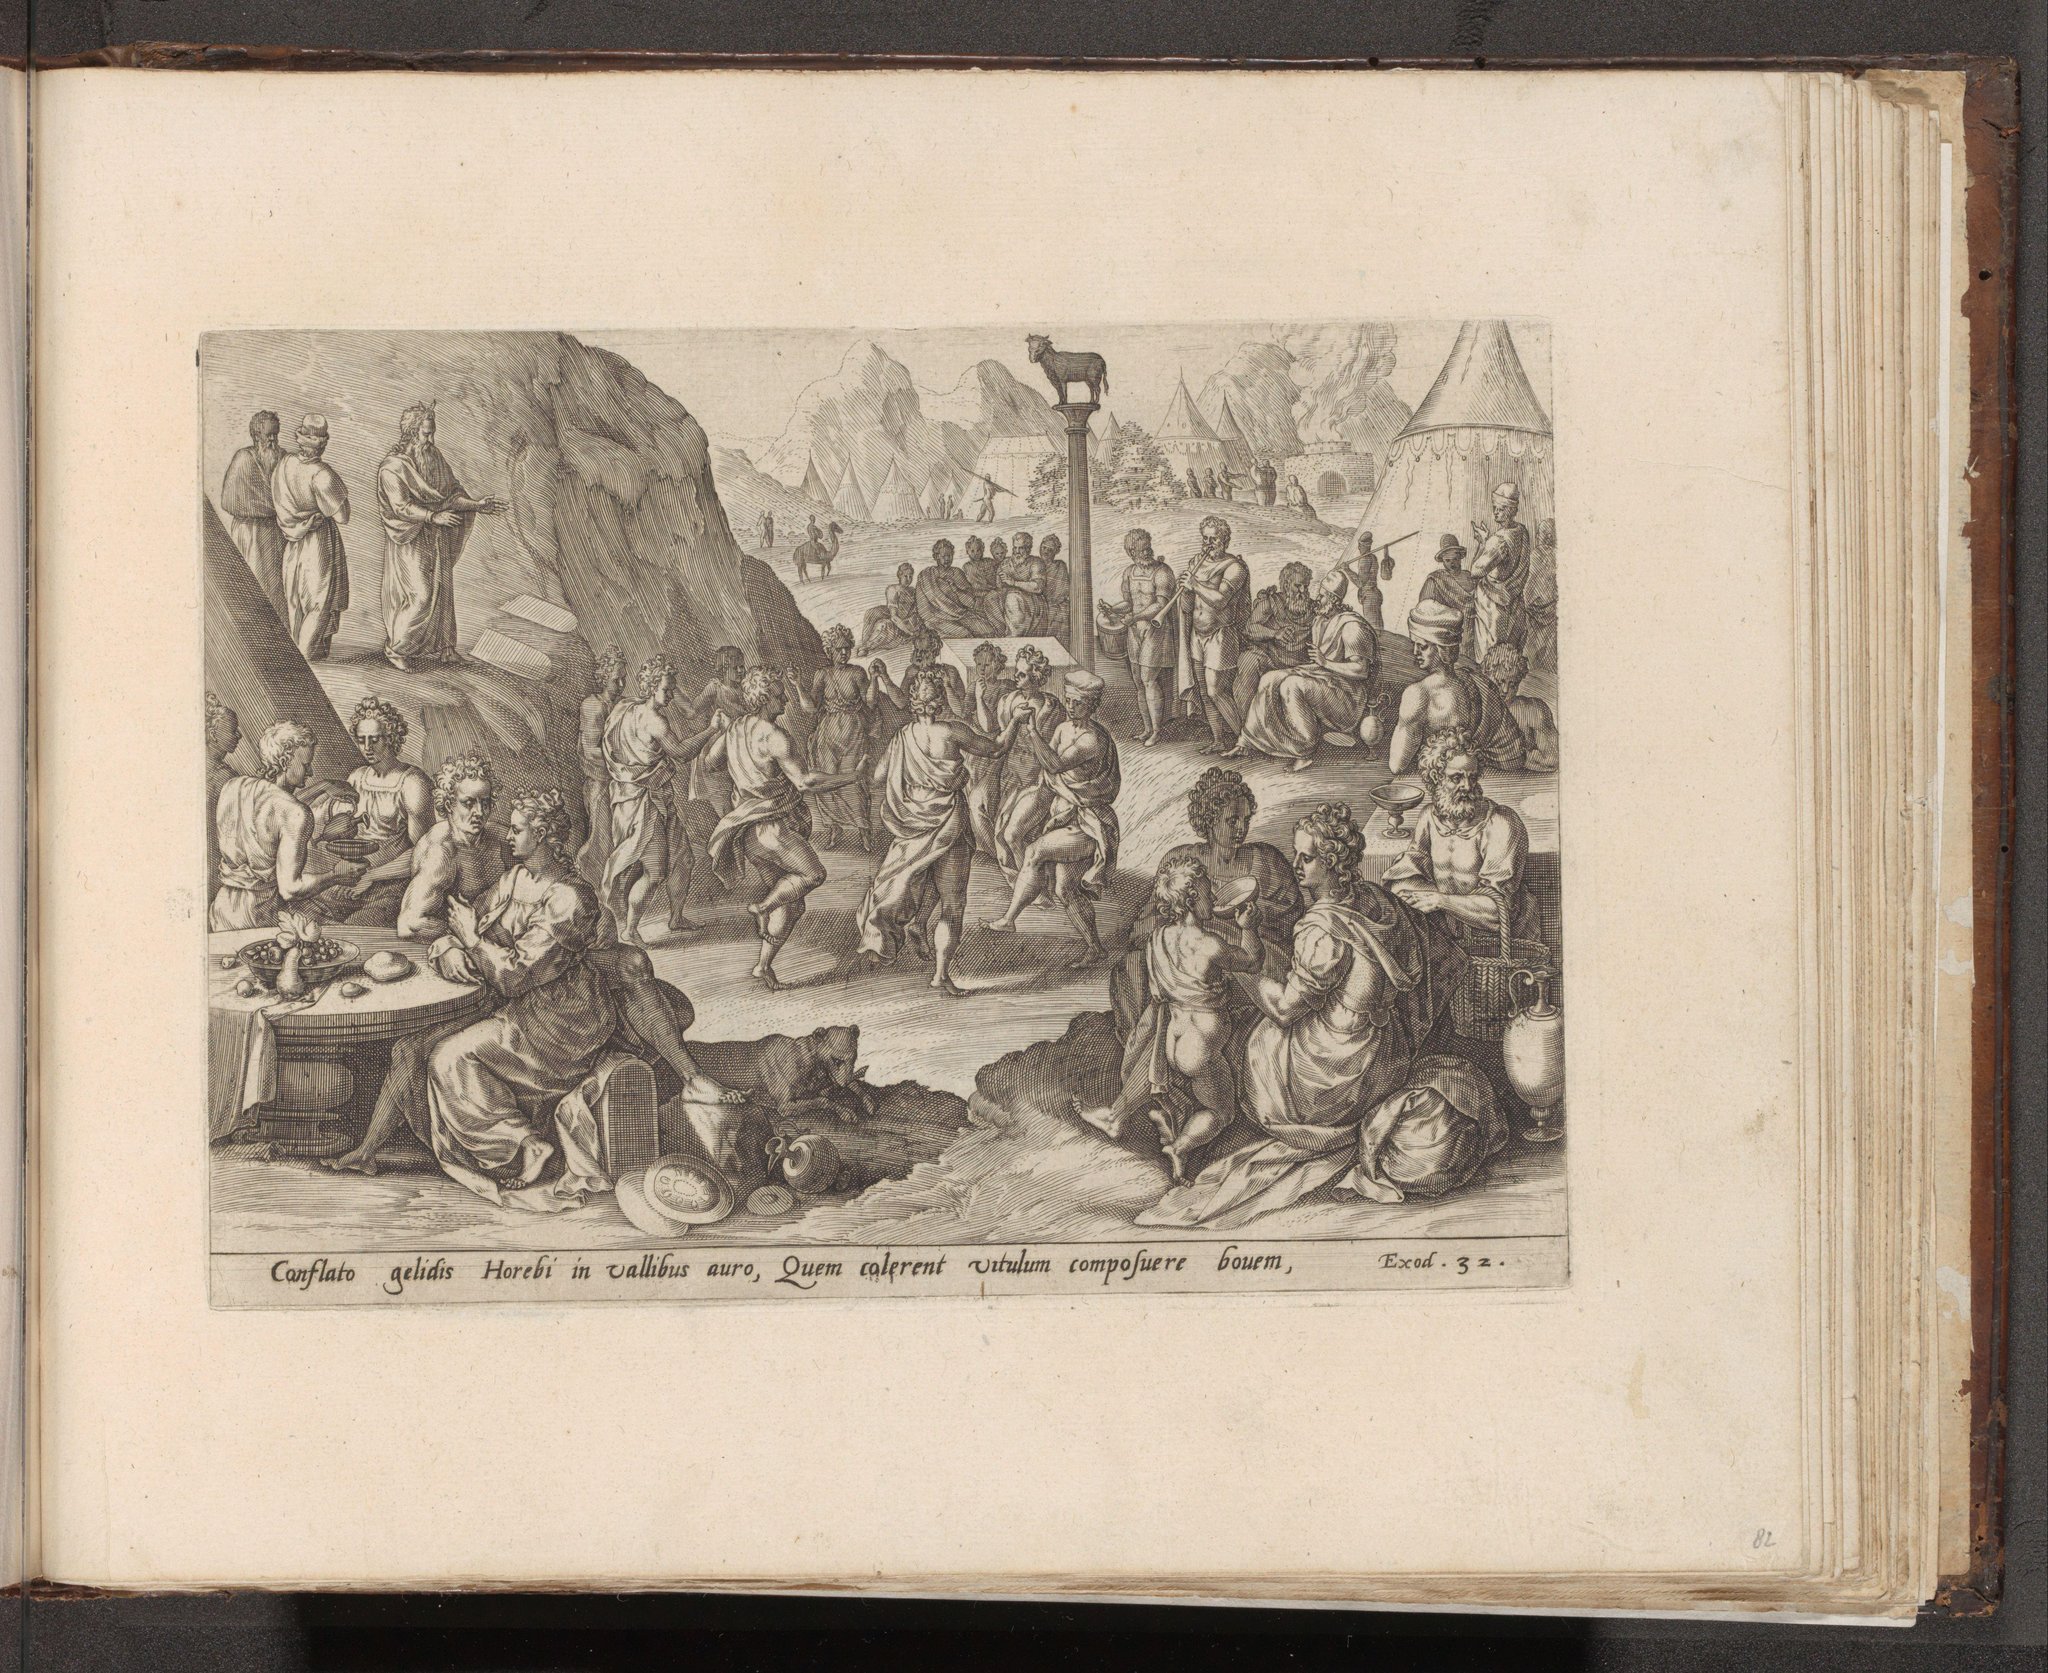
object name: album leaf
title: Dans rond het gouden kalf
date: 1579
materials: paper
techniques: engraving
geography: antwerp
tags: on seeing the idolaters moses breaks the tables of the law, the people dance around the golden calf ~ exodus, the people feasting ~ adoration of the golden calf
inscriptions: caption: ‘Conflato geldidis Horebi in vallibus auro...bovem Exod. 32.’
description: Het Joodse volk danst en maakt muziek rond een pilaar met het gouden kalf. Op de voorgrond wordt een feestmaal gegeten. Links op een heuvel breekt Mozes de tafelen der wet op de grond. Onder de voorstelling een verwijzing in het Latijn naar de Bijbeltekst in Ex. 32. Prent maakt deel uit van een album.